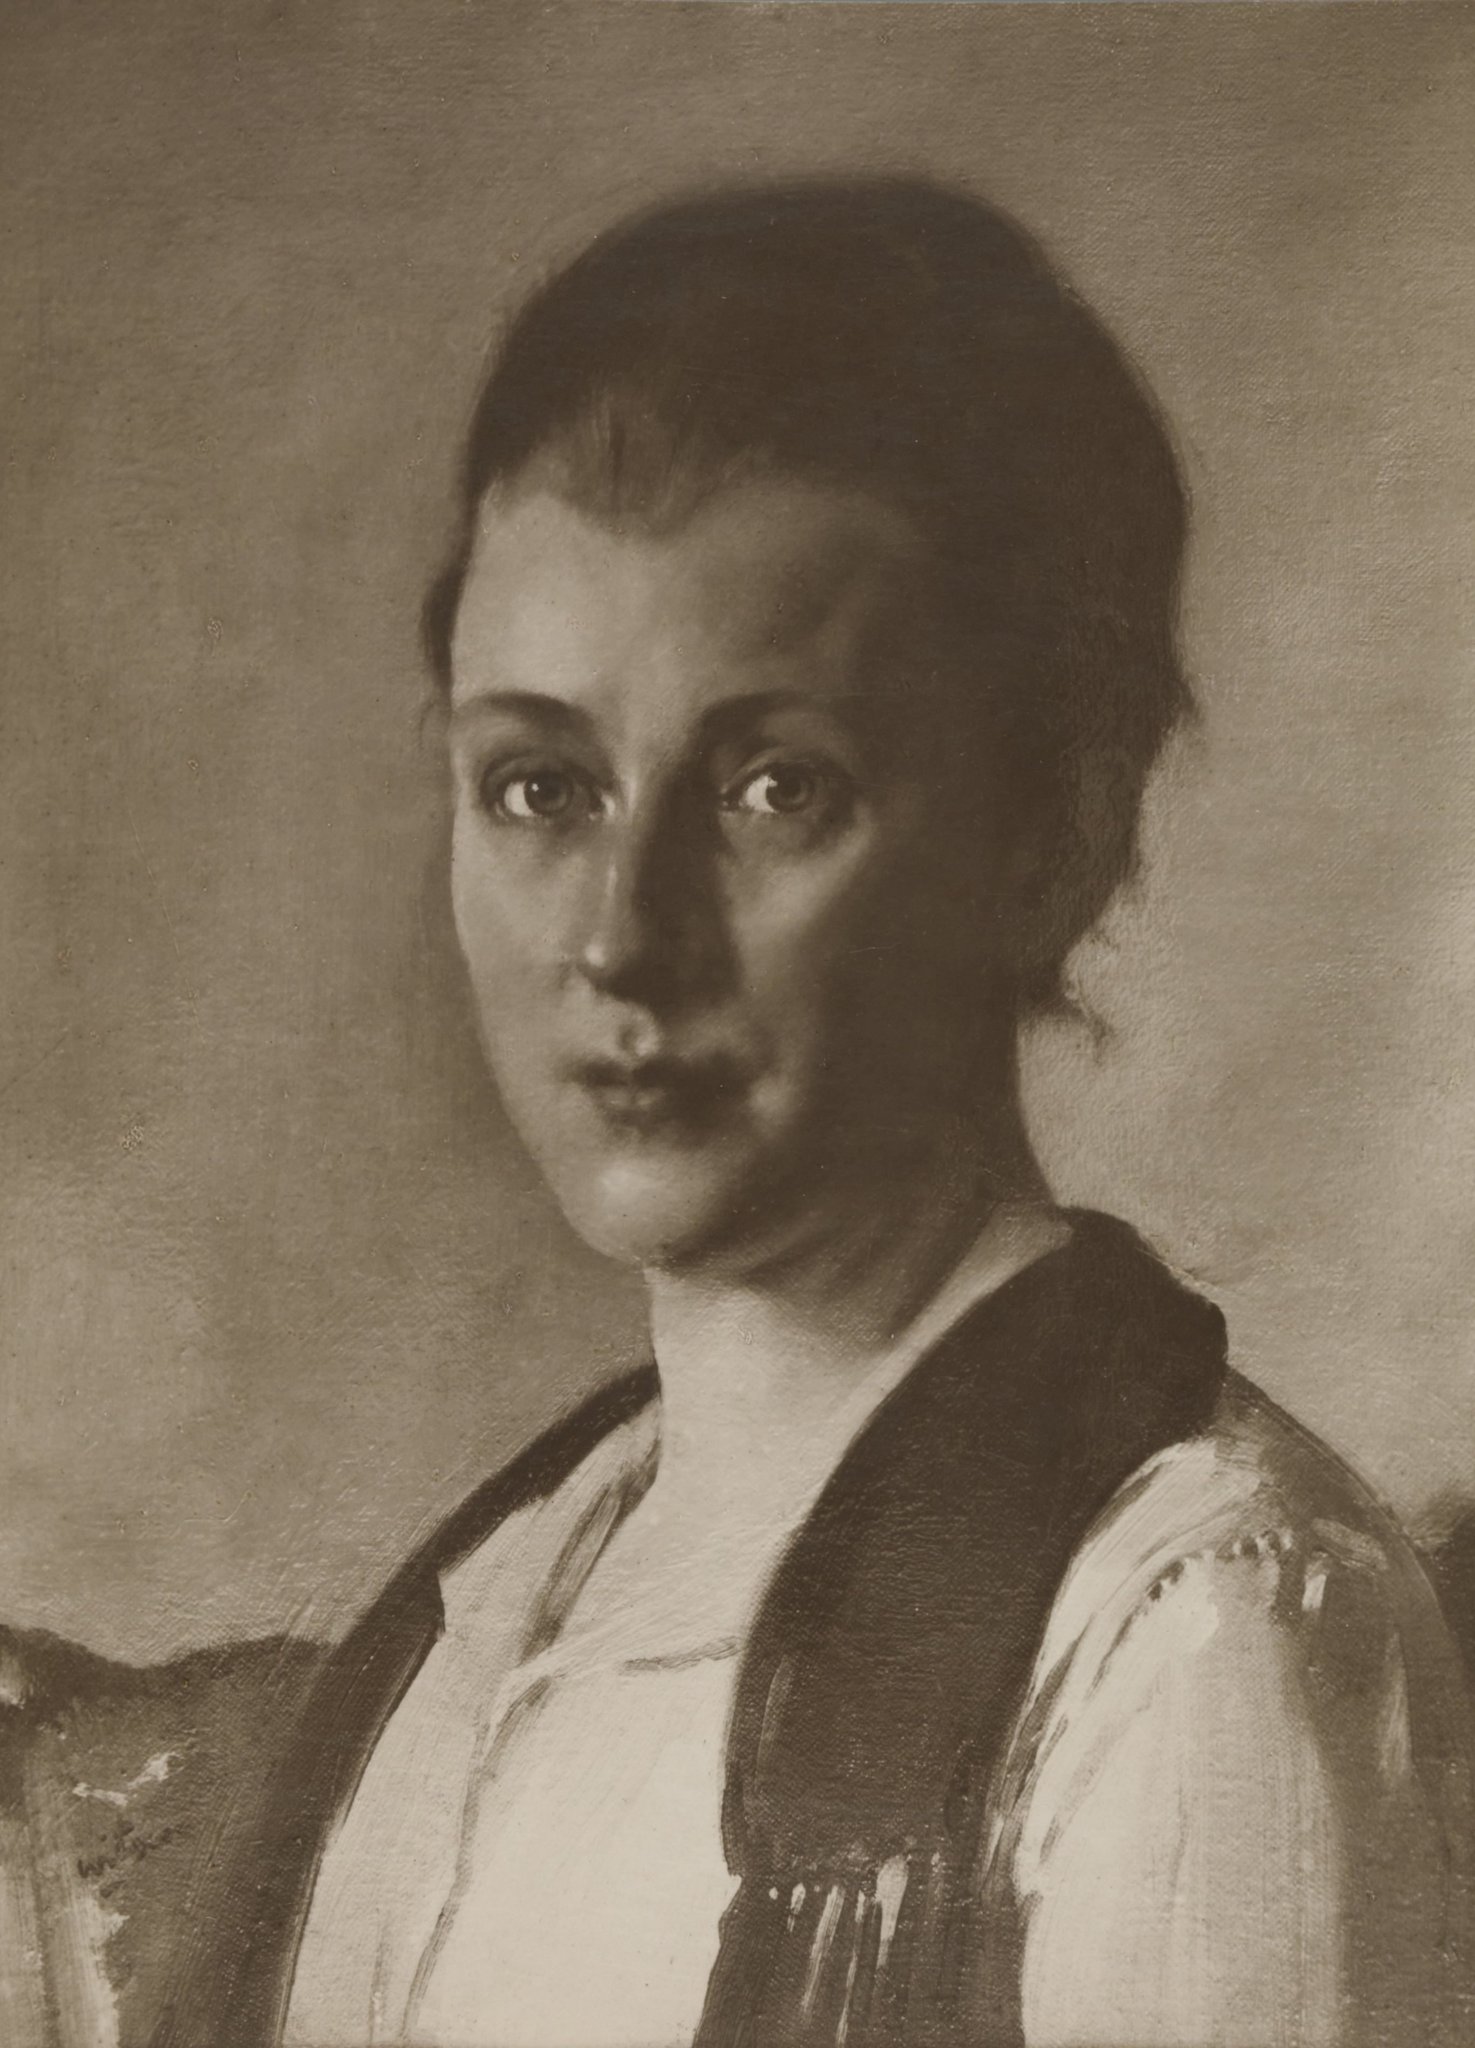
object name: photograph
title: Reproductie naar een foto, schilderij, tekening of prent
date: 1860-1915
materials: paper, photographic support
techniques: gelatin silver print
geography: netherlands